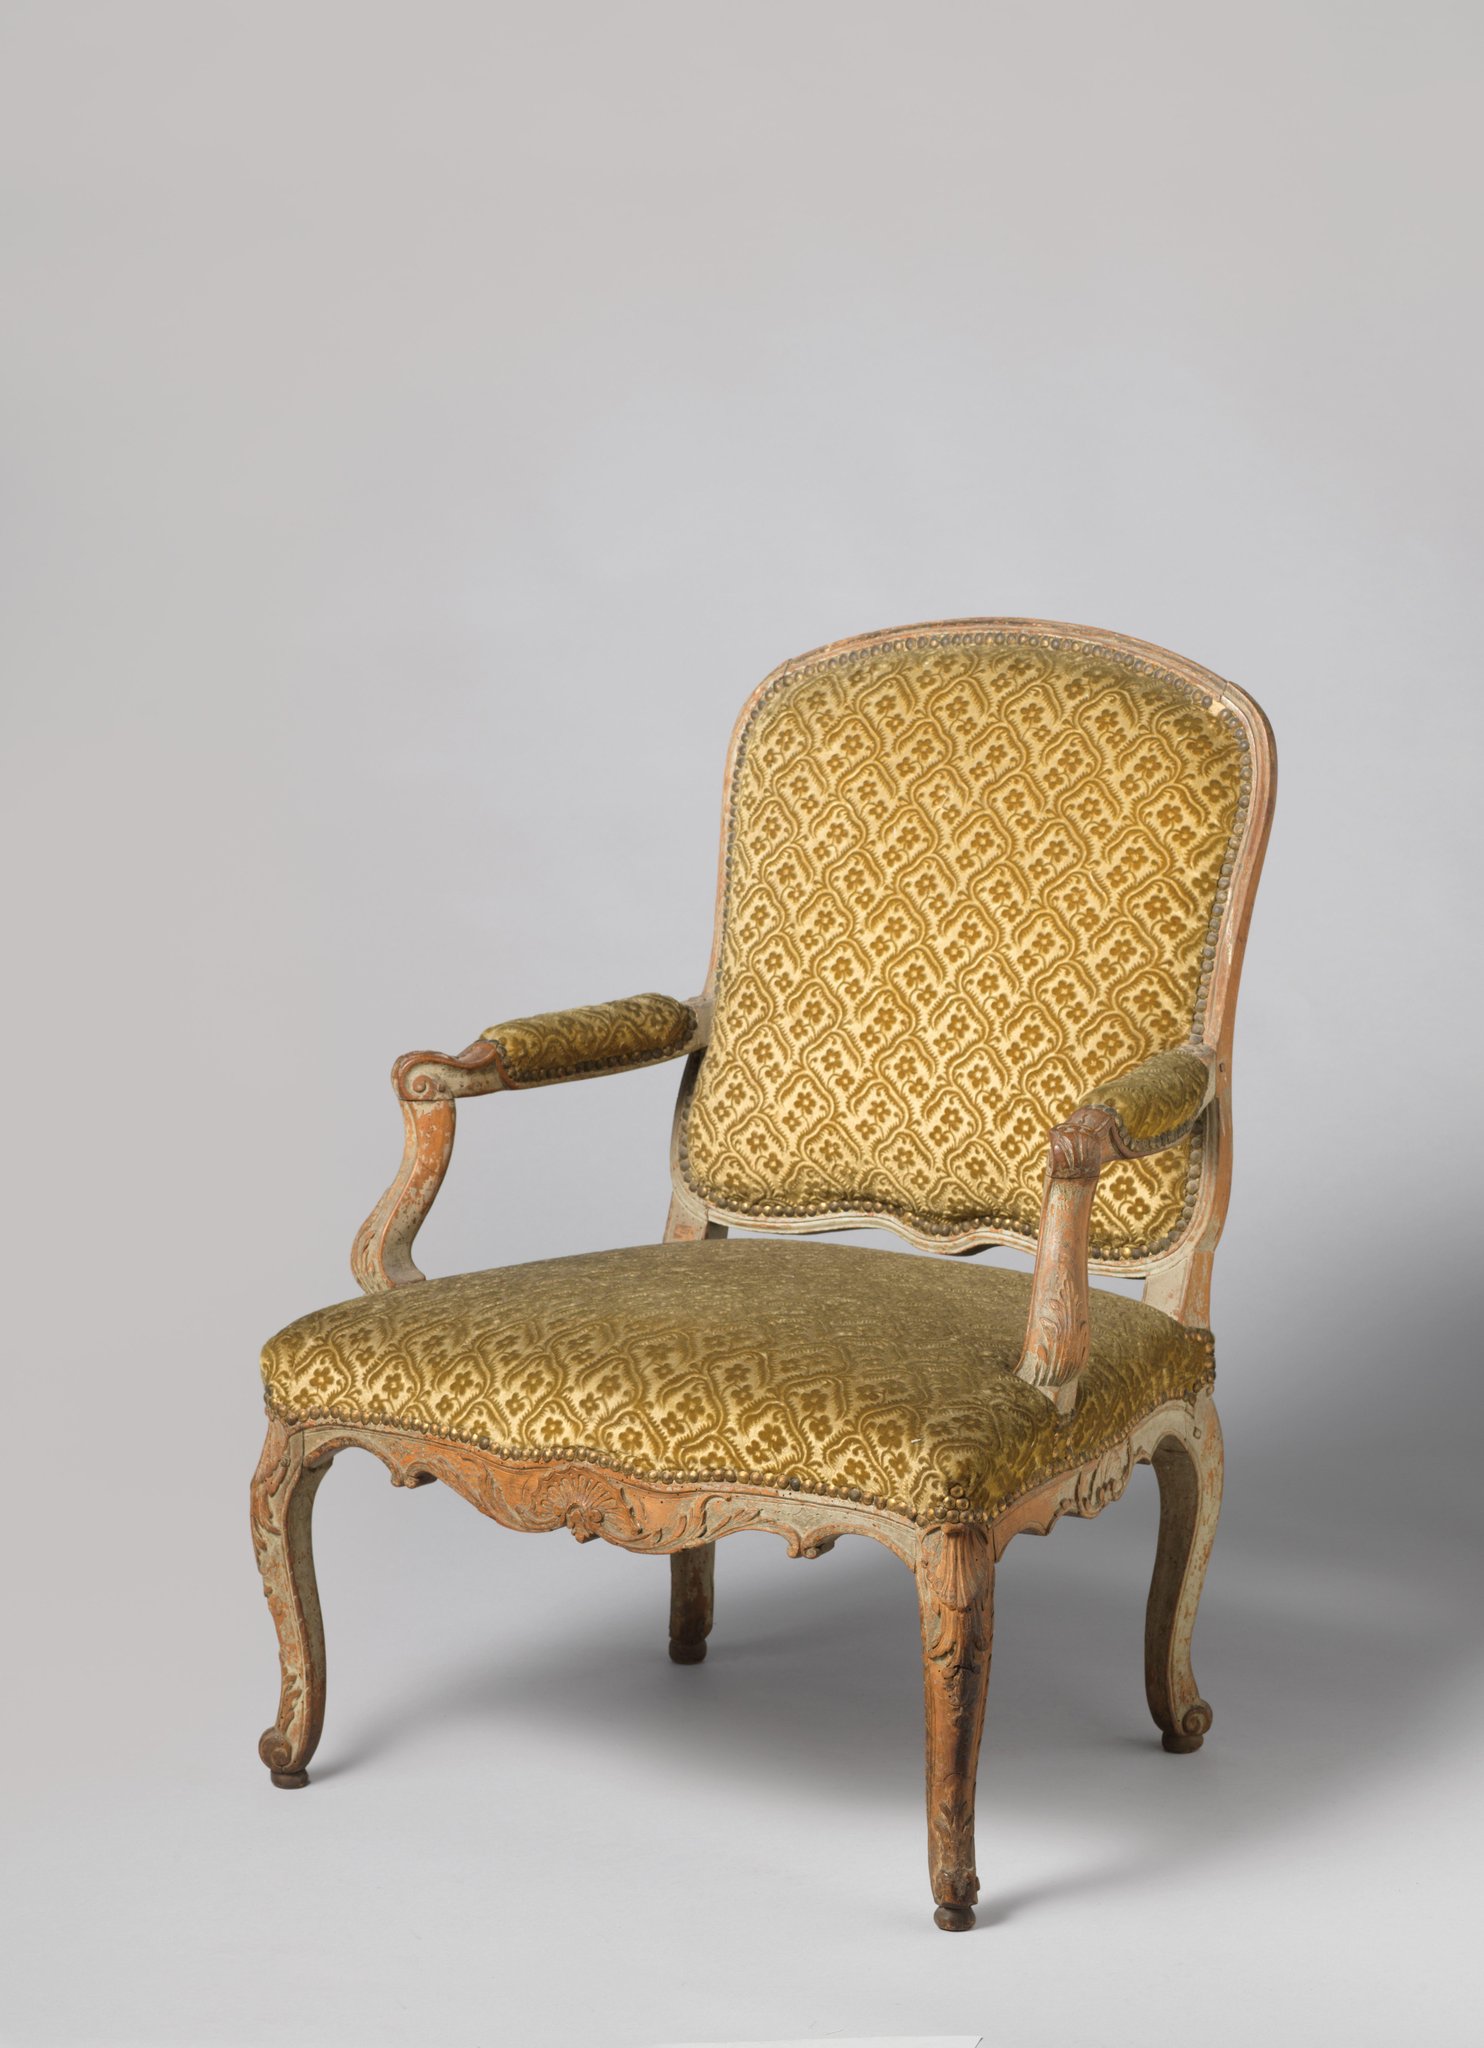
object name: armchair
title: Armstoel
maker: Anonymous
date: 1700-1750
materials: wood, textile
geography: france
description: Armstoel, bekleed, van geschilderd beukenhout. De overhoeks geplaatste S-vormige poten gaan in het zitraam over. Zij dragen, evenals de geschulpte zitregels en de armleggerstutten gestoken versieringen. Het trapeziumvormige zitraam is aan de voorzijde gebogen. De buitenwaarts wijkende armleggers eindigen in een voluut; de stutten zijn achterwaarts geplaatst en gaan S-vormig in de armleggers over. Het rugraam op stutten, aan de bovenkant gebogen en met geschulpte onderkant, heeft gestrekt S-vormige stijlen.